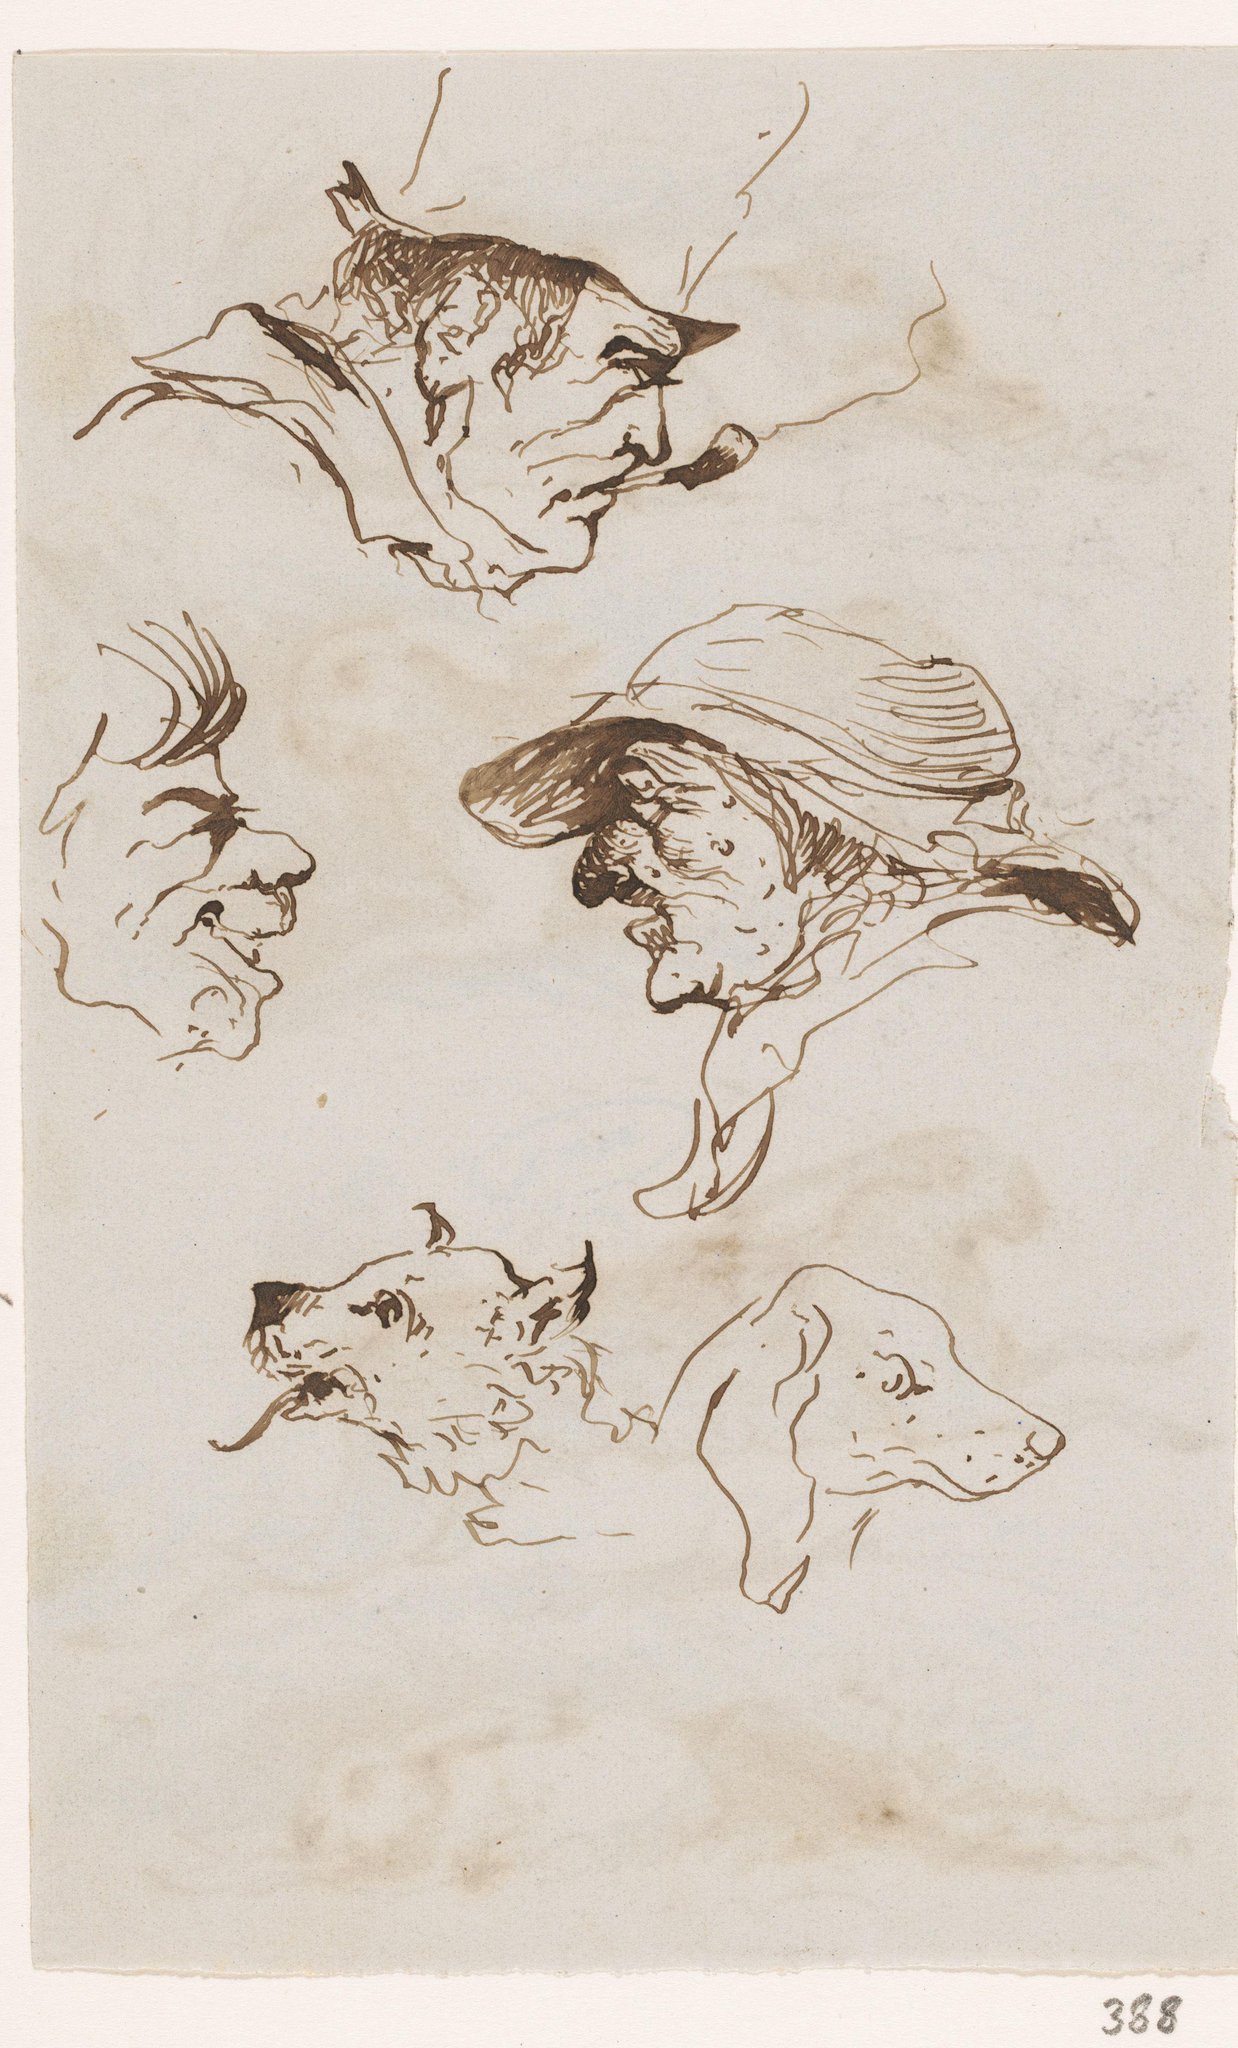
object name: drawing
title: Koppen en honden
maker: johannes tavenraat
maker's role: draughtsman, painter, print maker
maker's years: 1809-1881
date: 1840-1880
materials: ink, paper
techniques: pen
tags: caricatures (human types), dog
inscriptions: collector's mark: Lugt 2228